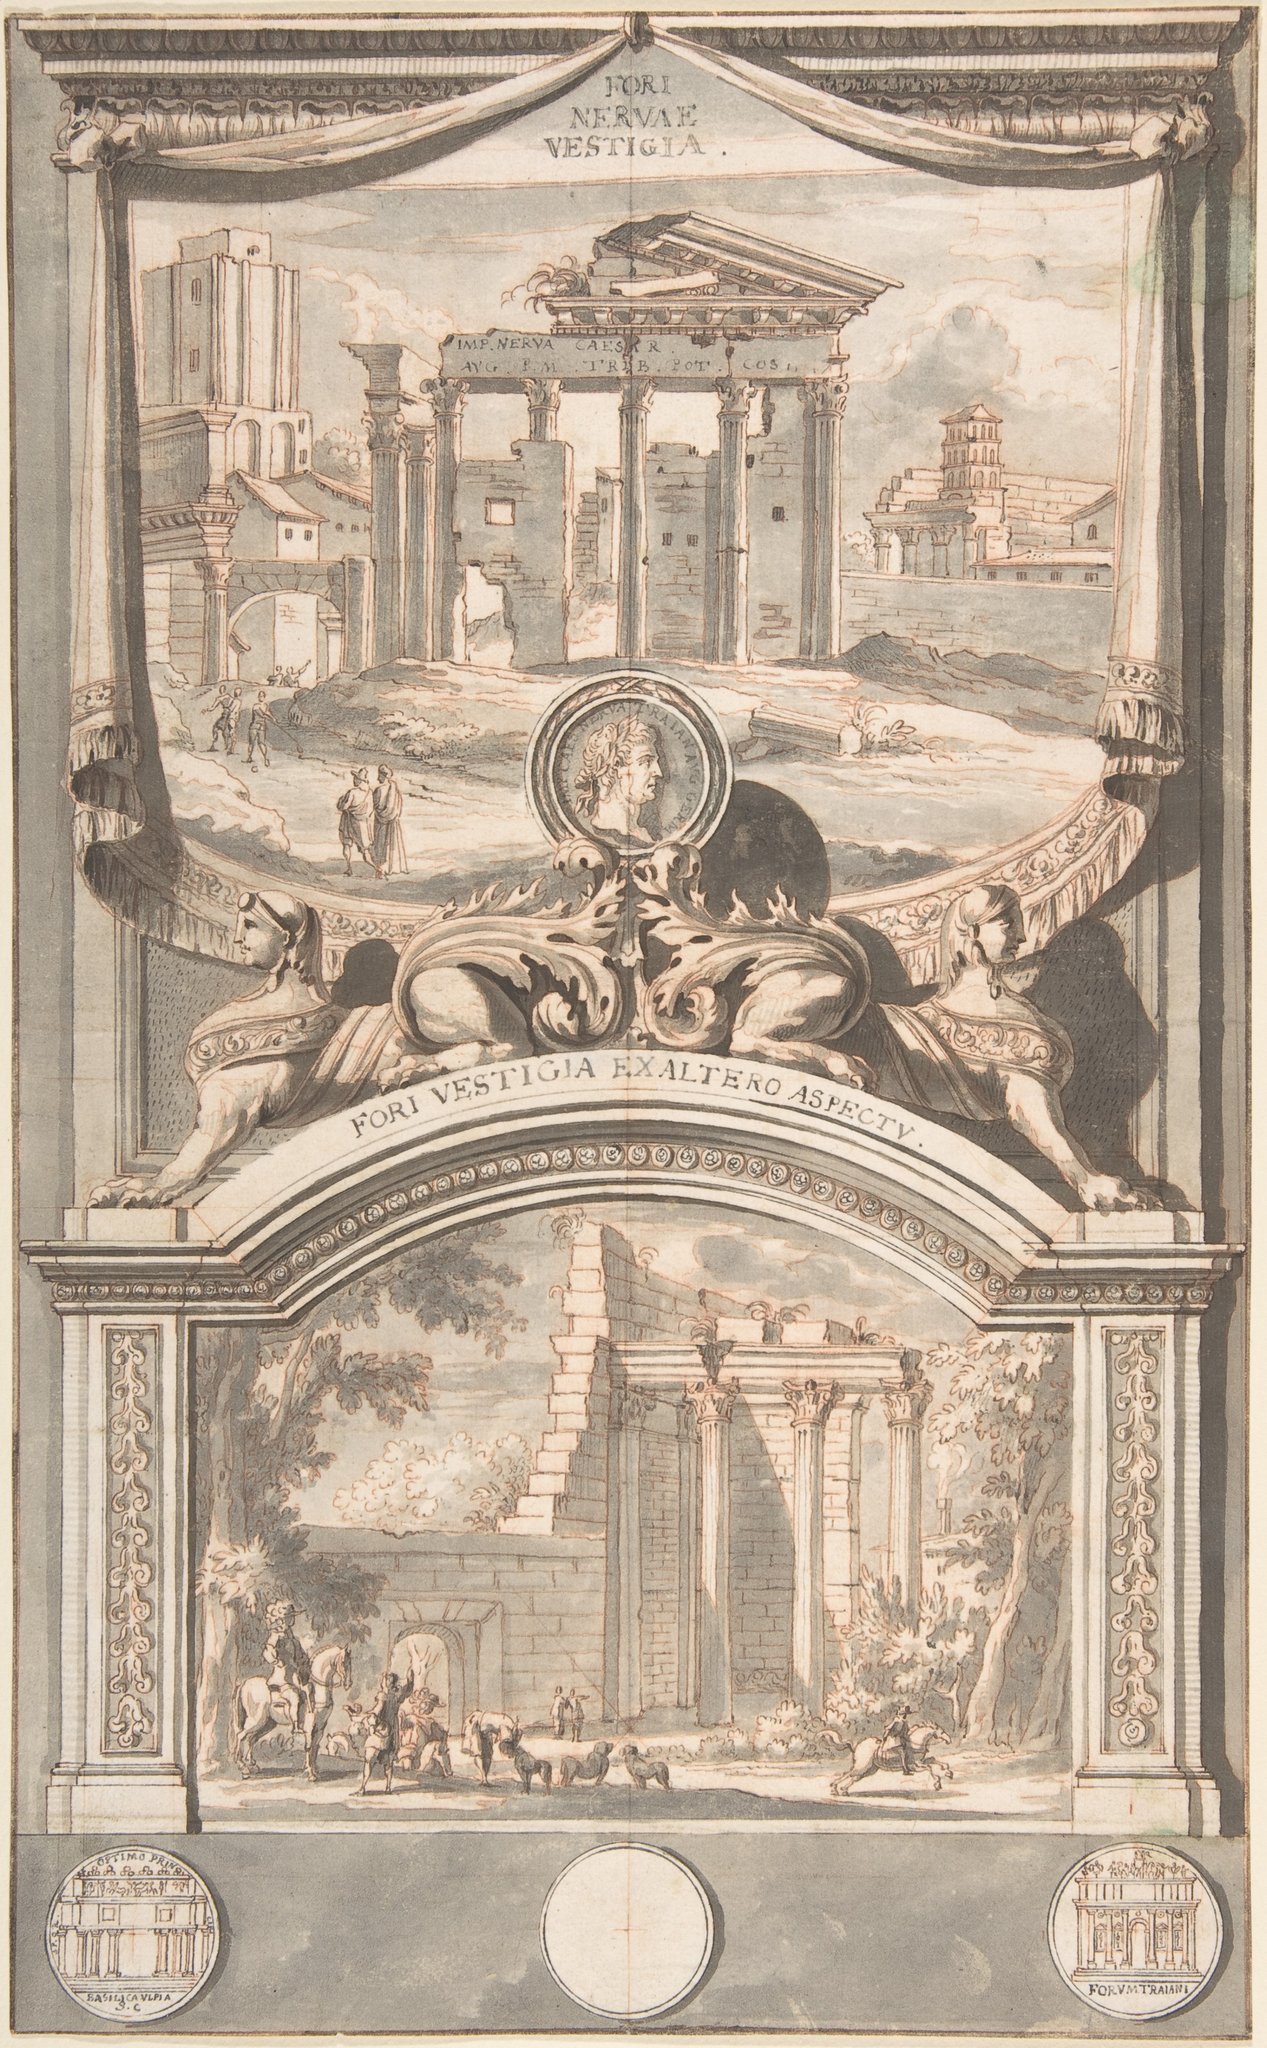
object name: drawing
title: Ruins of the Forum of Nerva (above) and Another View of the Ruins (below)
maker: jan goeree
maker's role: artist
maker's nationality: dutch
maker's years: 1670-1731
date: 1704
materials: chalk, ink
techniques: brush, pen, wash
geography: italy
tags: temples,ruins,sphinx